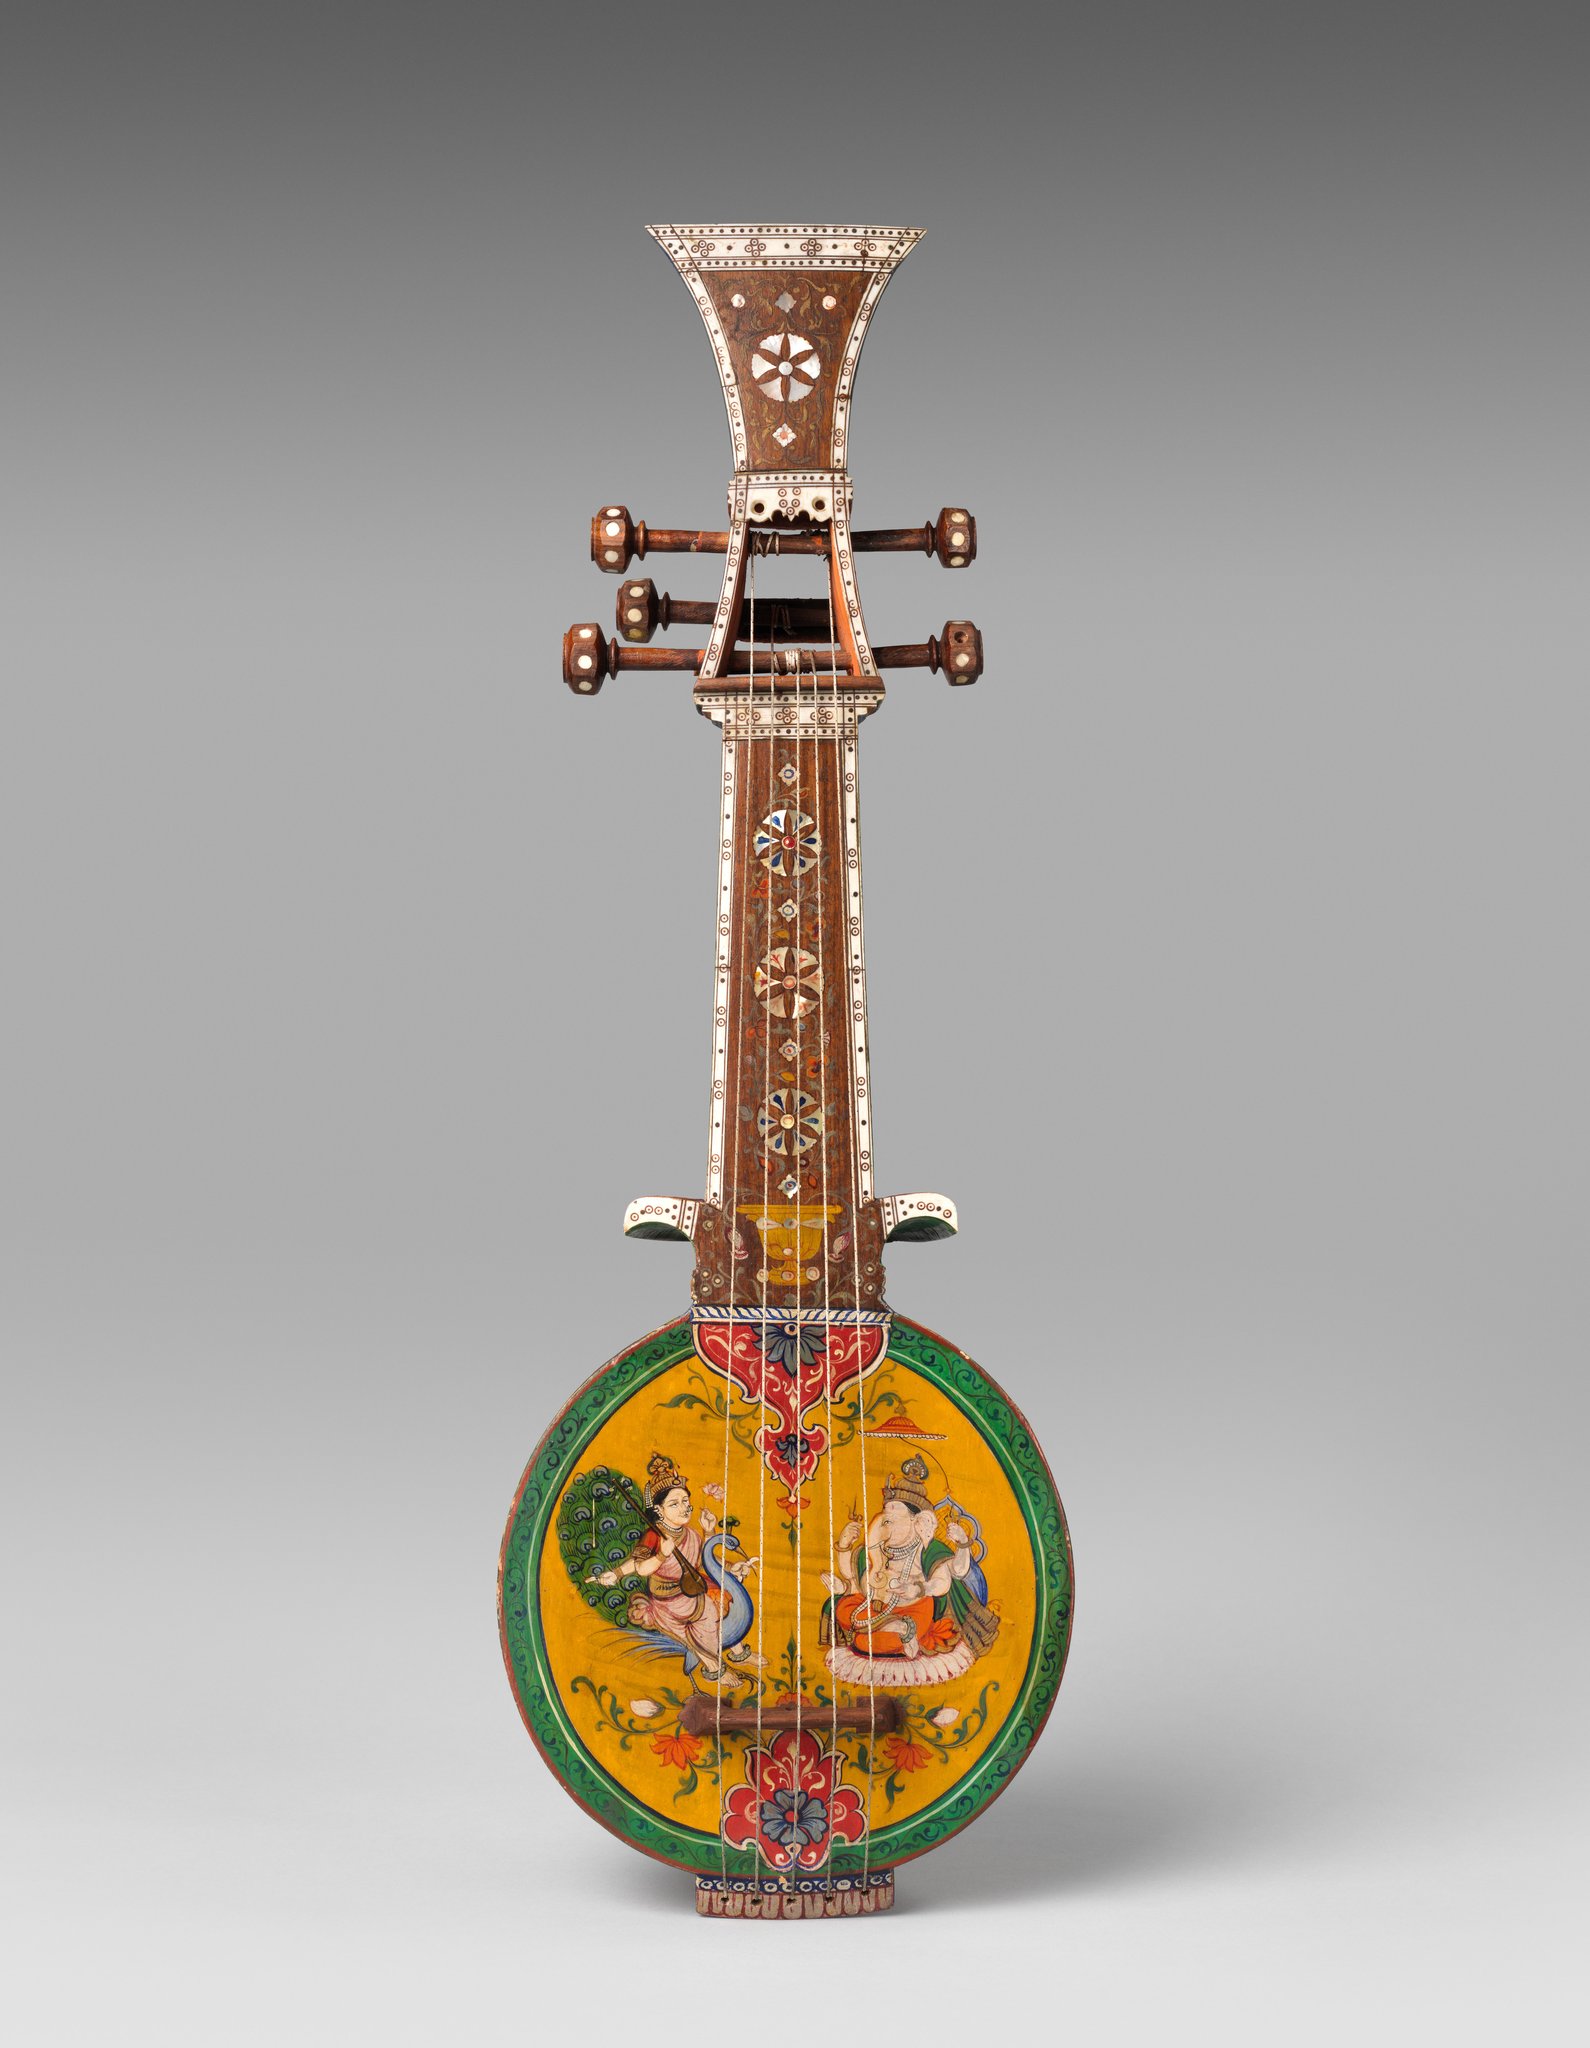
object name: sursanga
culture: indian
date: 1801-1900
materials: ivory, pearl, wood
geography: india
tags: peacocks,ganesha